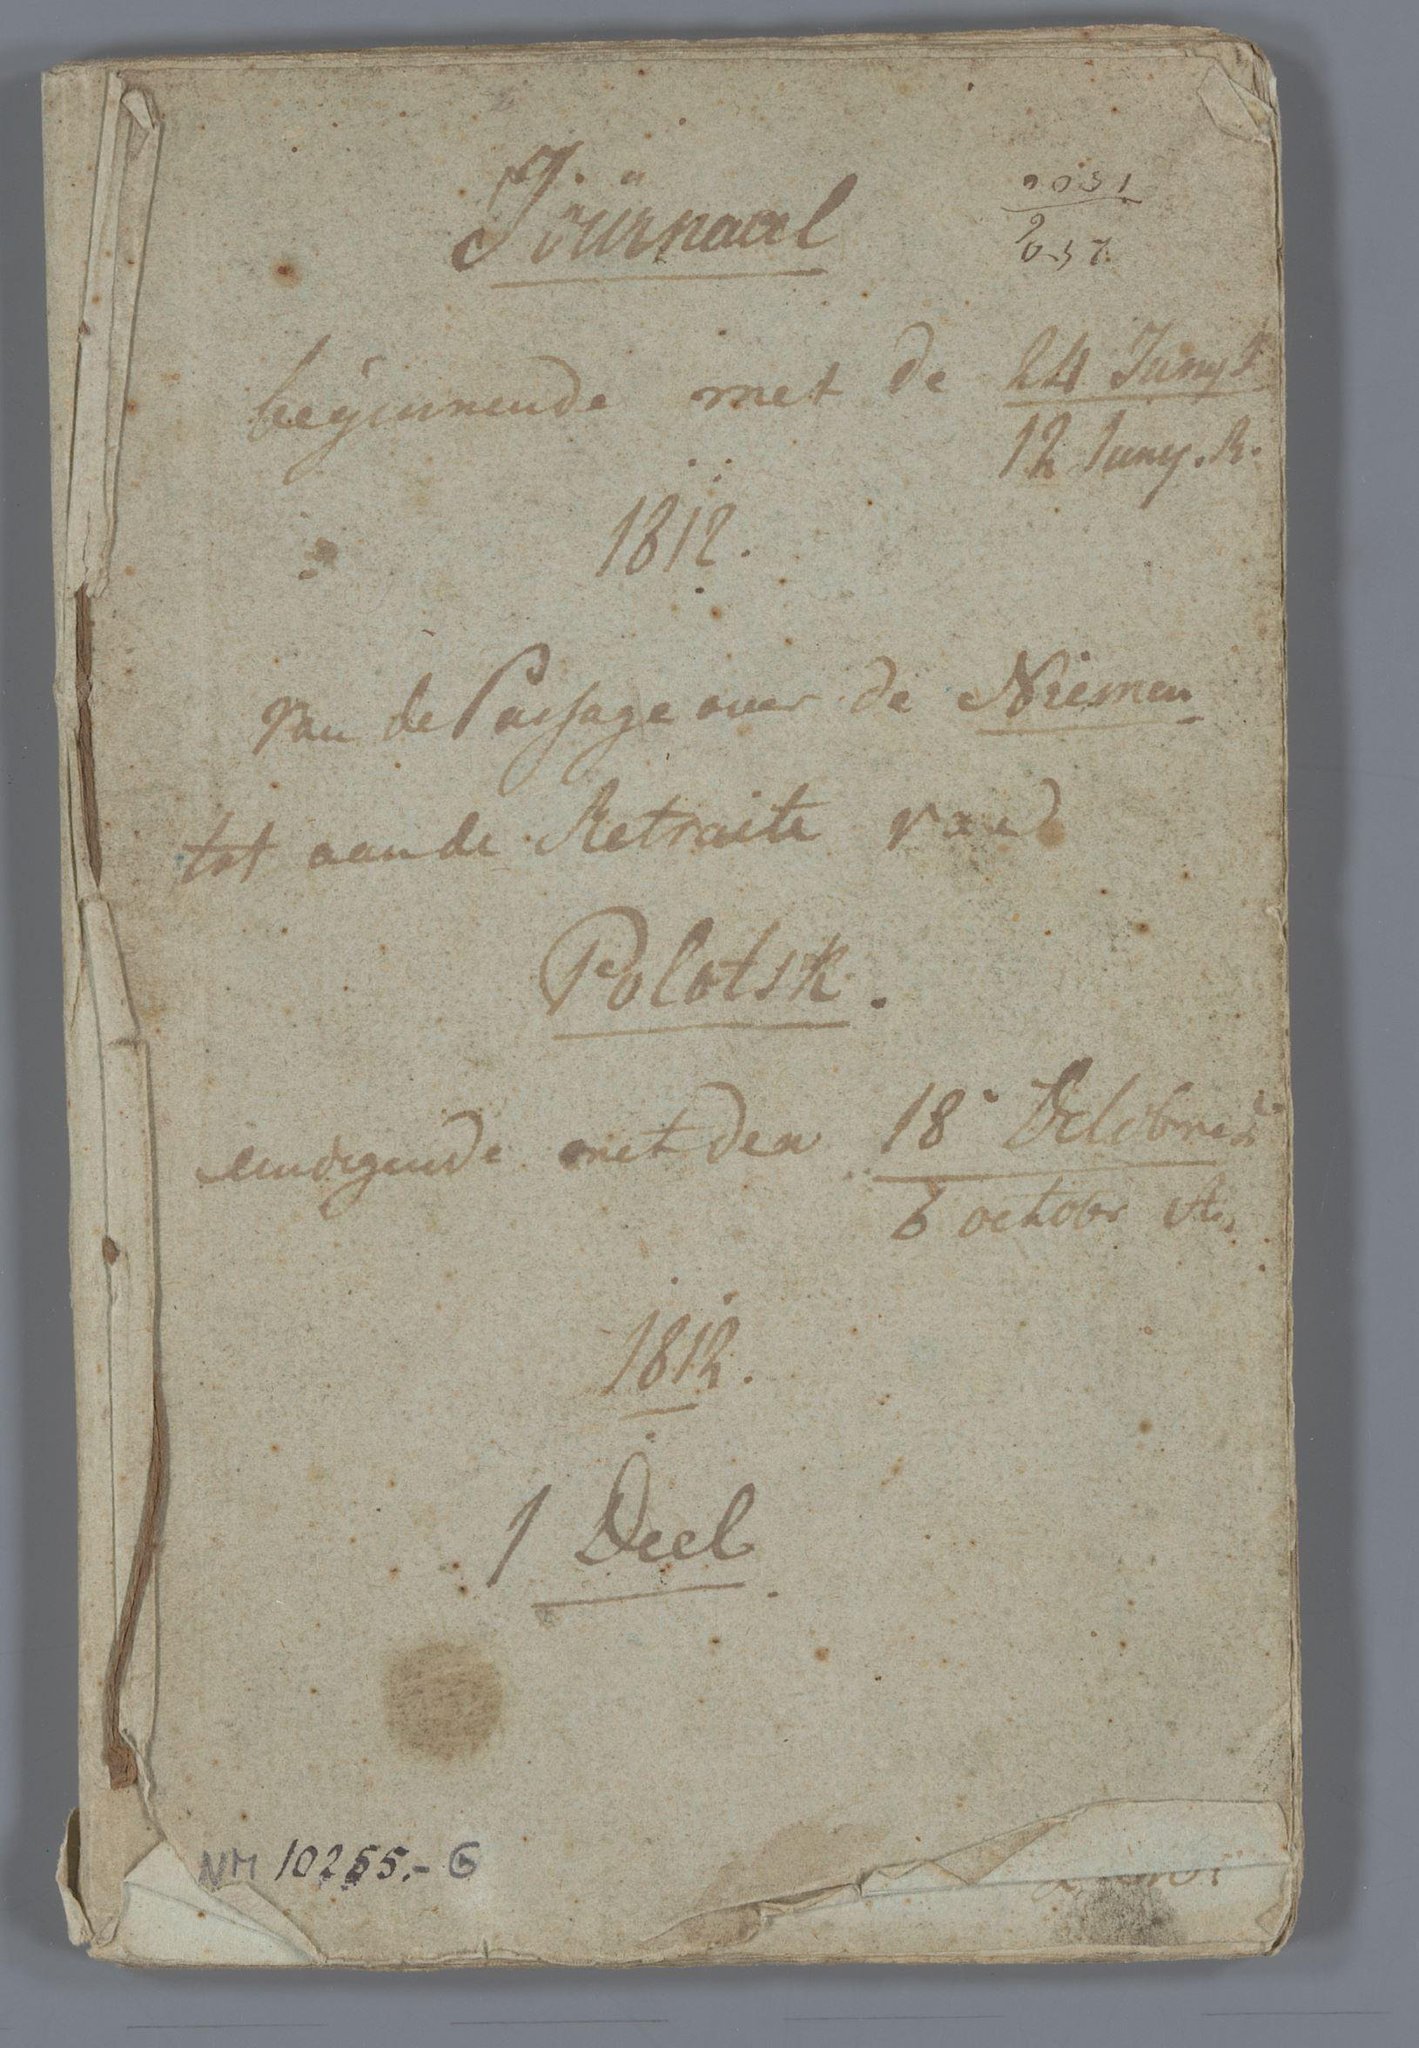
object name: book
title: Journaal beginnende met de 24 Juny / 12 Juny 1812 van de Passage over de Niemen tot aan de Retraite van Polotsk eindigende met de 18 October / 6 October 1812. 1 Deel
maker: c.j. baron krayenhoff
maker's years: 1788-1865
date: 1812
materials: ink, paper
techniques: bookbinding, writing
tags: c.j. baron krayenhoff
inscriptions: date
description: Met de hand beschreven boekje van groenig papier, 60 pp, niet genummerd. met touwtje bijeengebonden, zonder aparte omslag. Gedateerd: voorpagina: 24 Juny / 12 Juny 1812 (...) 18 October / 6 October 1812.